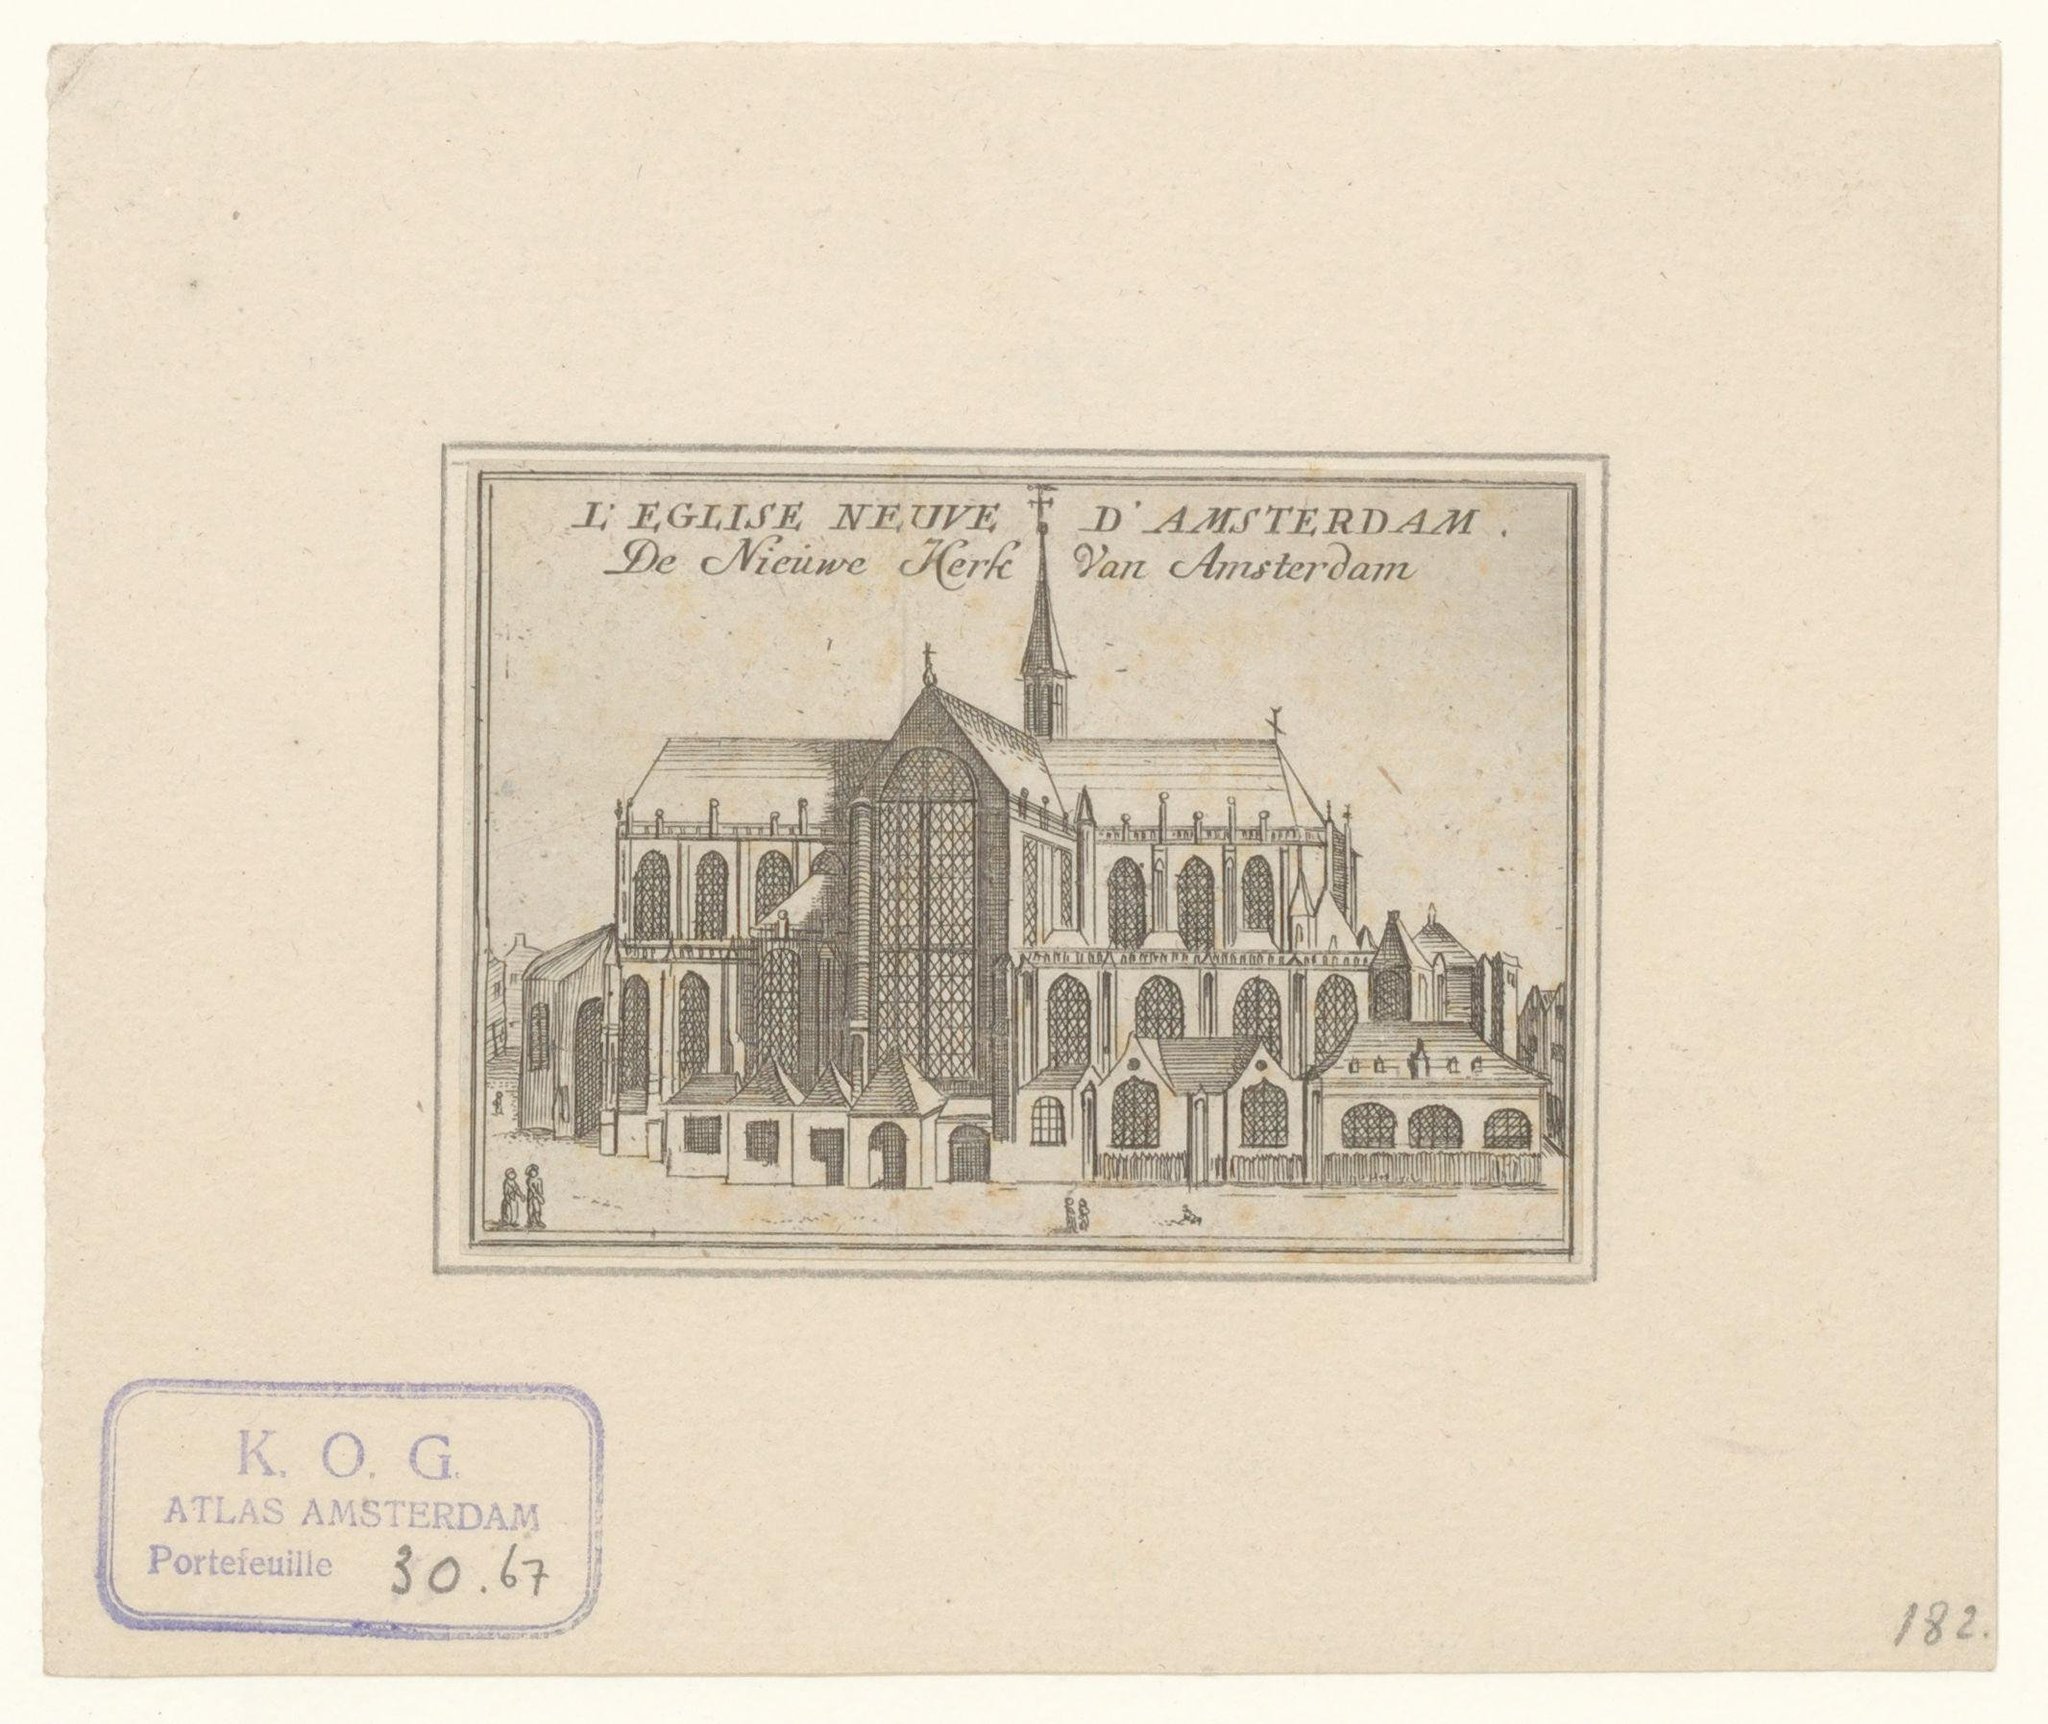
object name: print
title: L'Eglise Neuve d'Amsterdam / De Nieuwe Kerk van Amsterdam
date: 1785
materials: paper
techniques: engraving, etching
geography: antwerp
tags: church (exterior)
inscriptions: collector's mark: Lugt 1641b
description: Onderdeel van een grotere prent met voorstellingen van de Oude Kerk, de Beurs van Hendrik de Keyser en de Waag op de Dam te Amsterdam, zie RP-P-2019-287. Onderwerpsrubriek binnen de Atlas Amsterdam: Kerkwezen: Hervormde Gemeente: Nieuwe Kerk van buiten.